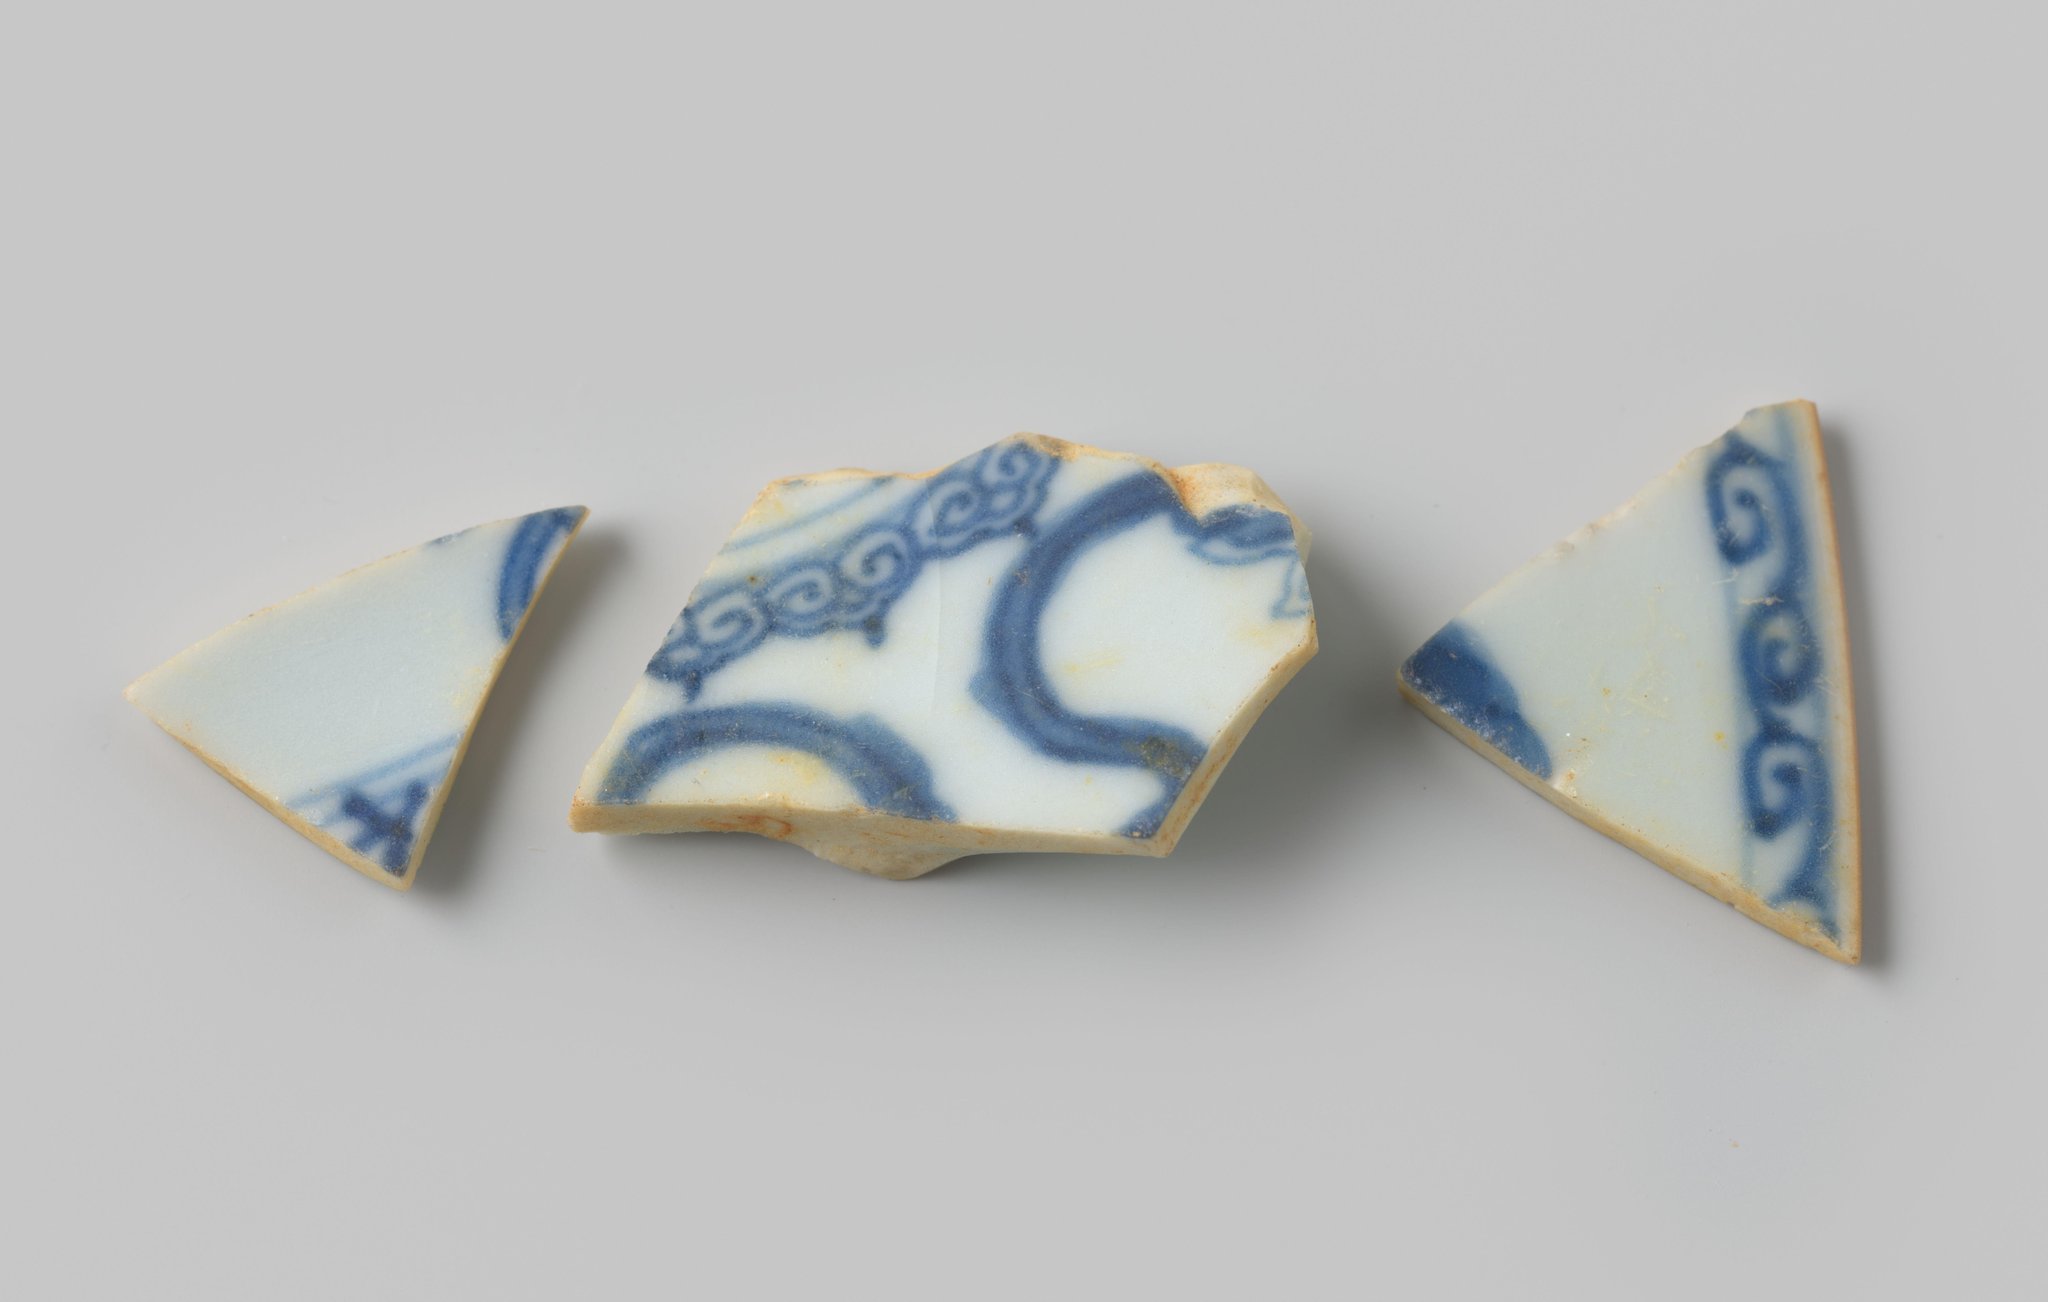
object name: sherd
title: Scherven van een schotel uit het wrak van de Oost-Indiëvaarder Hollandia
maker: Anonymous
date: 1700-1743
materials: porcelain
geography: netherlands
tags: verenigde oostindische compagnie, hollandia (schip), annet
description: Porcelain, saucer, type 2; fragm of base, fragm of rim sim. NG 1979-209H1318.